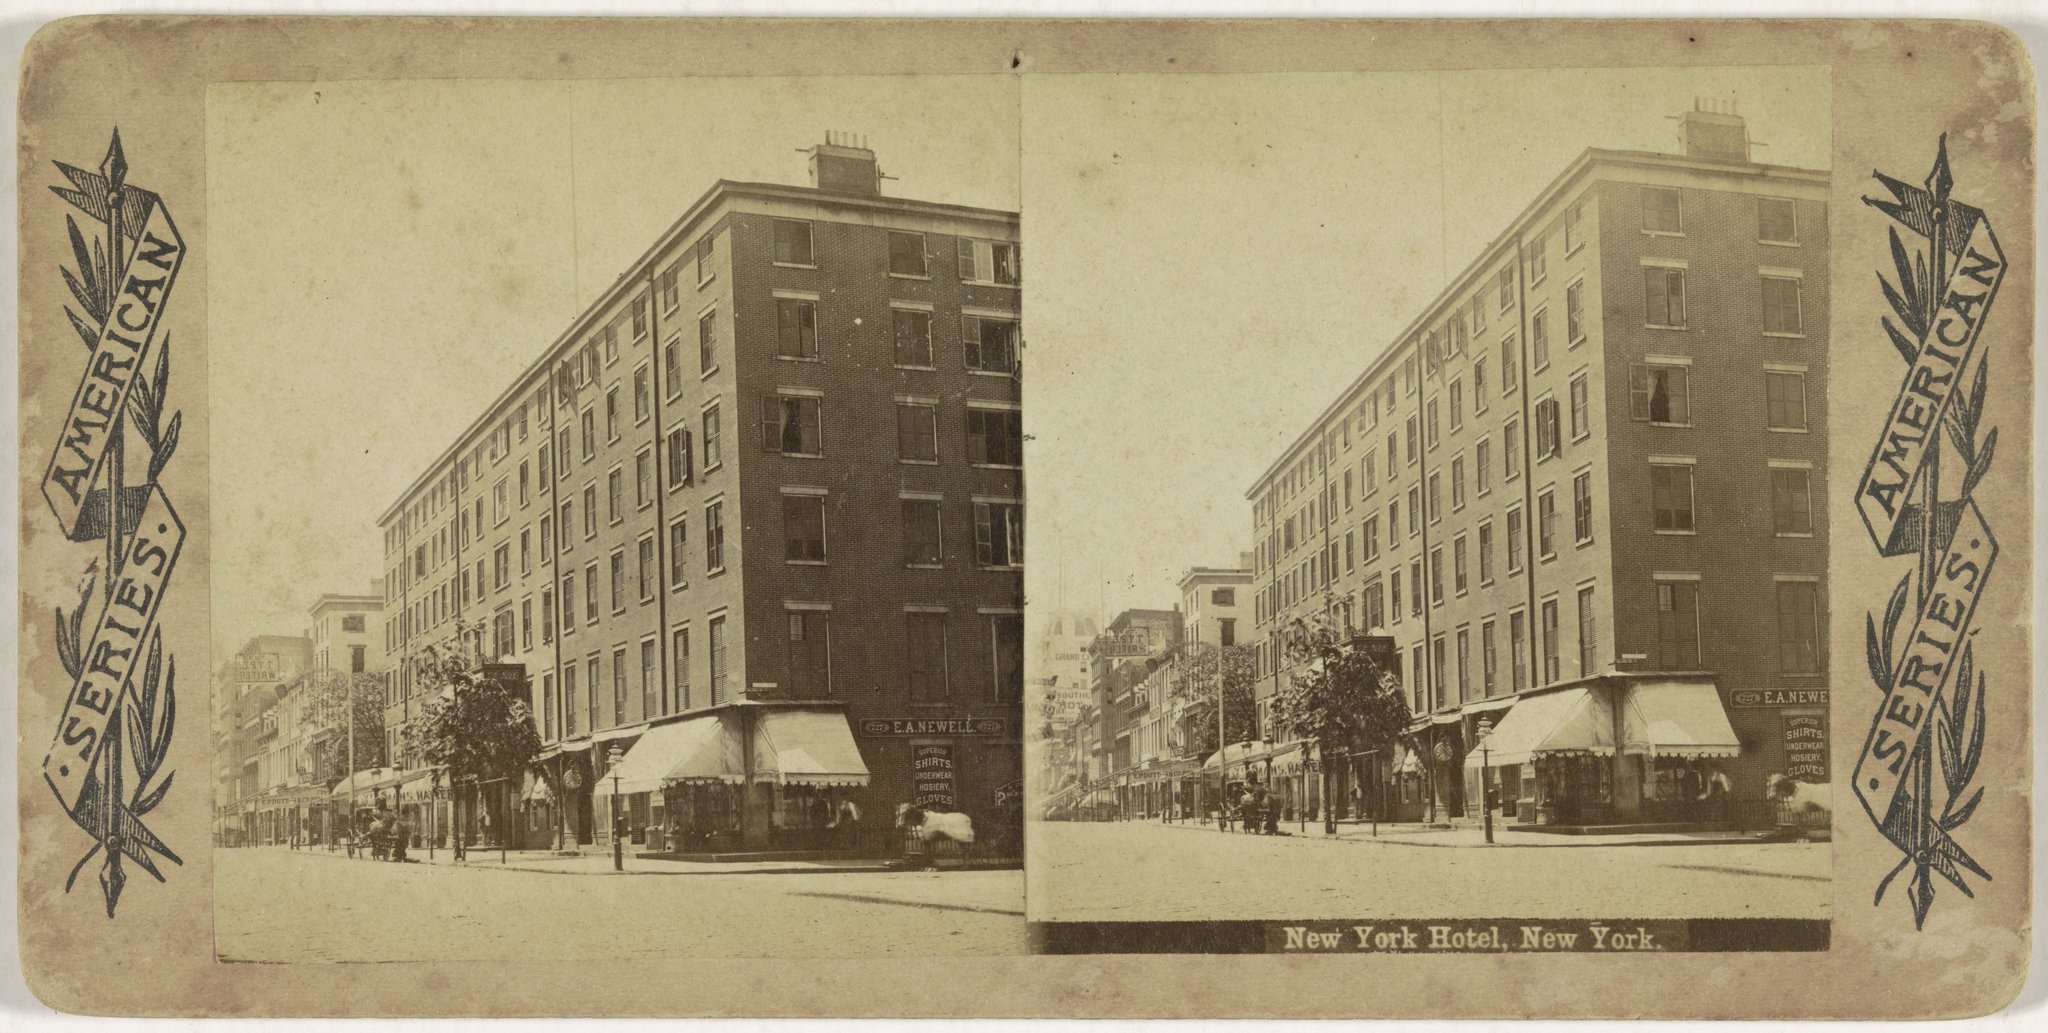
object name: stereograph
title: Gezicht op het New York Hotel in New York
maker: Anonymous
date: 1850-1880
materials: cardboard, paper, photographic support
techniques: albumen print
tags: new york (city)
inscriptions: inscription: ‘€1250 (?) / 15.’